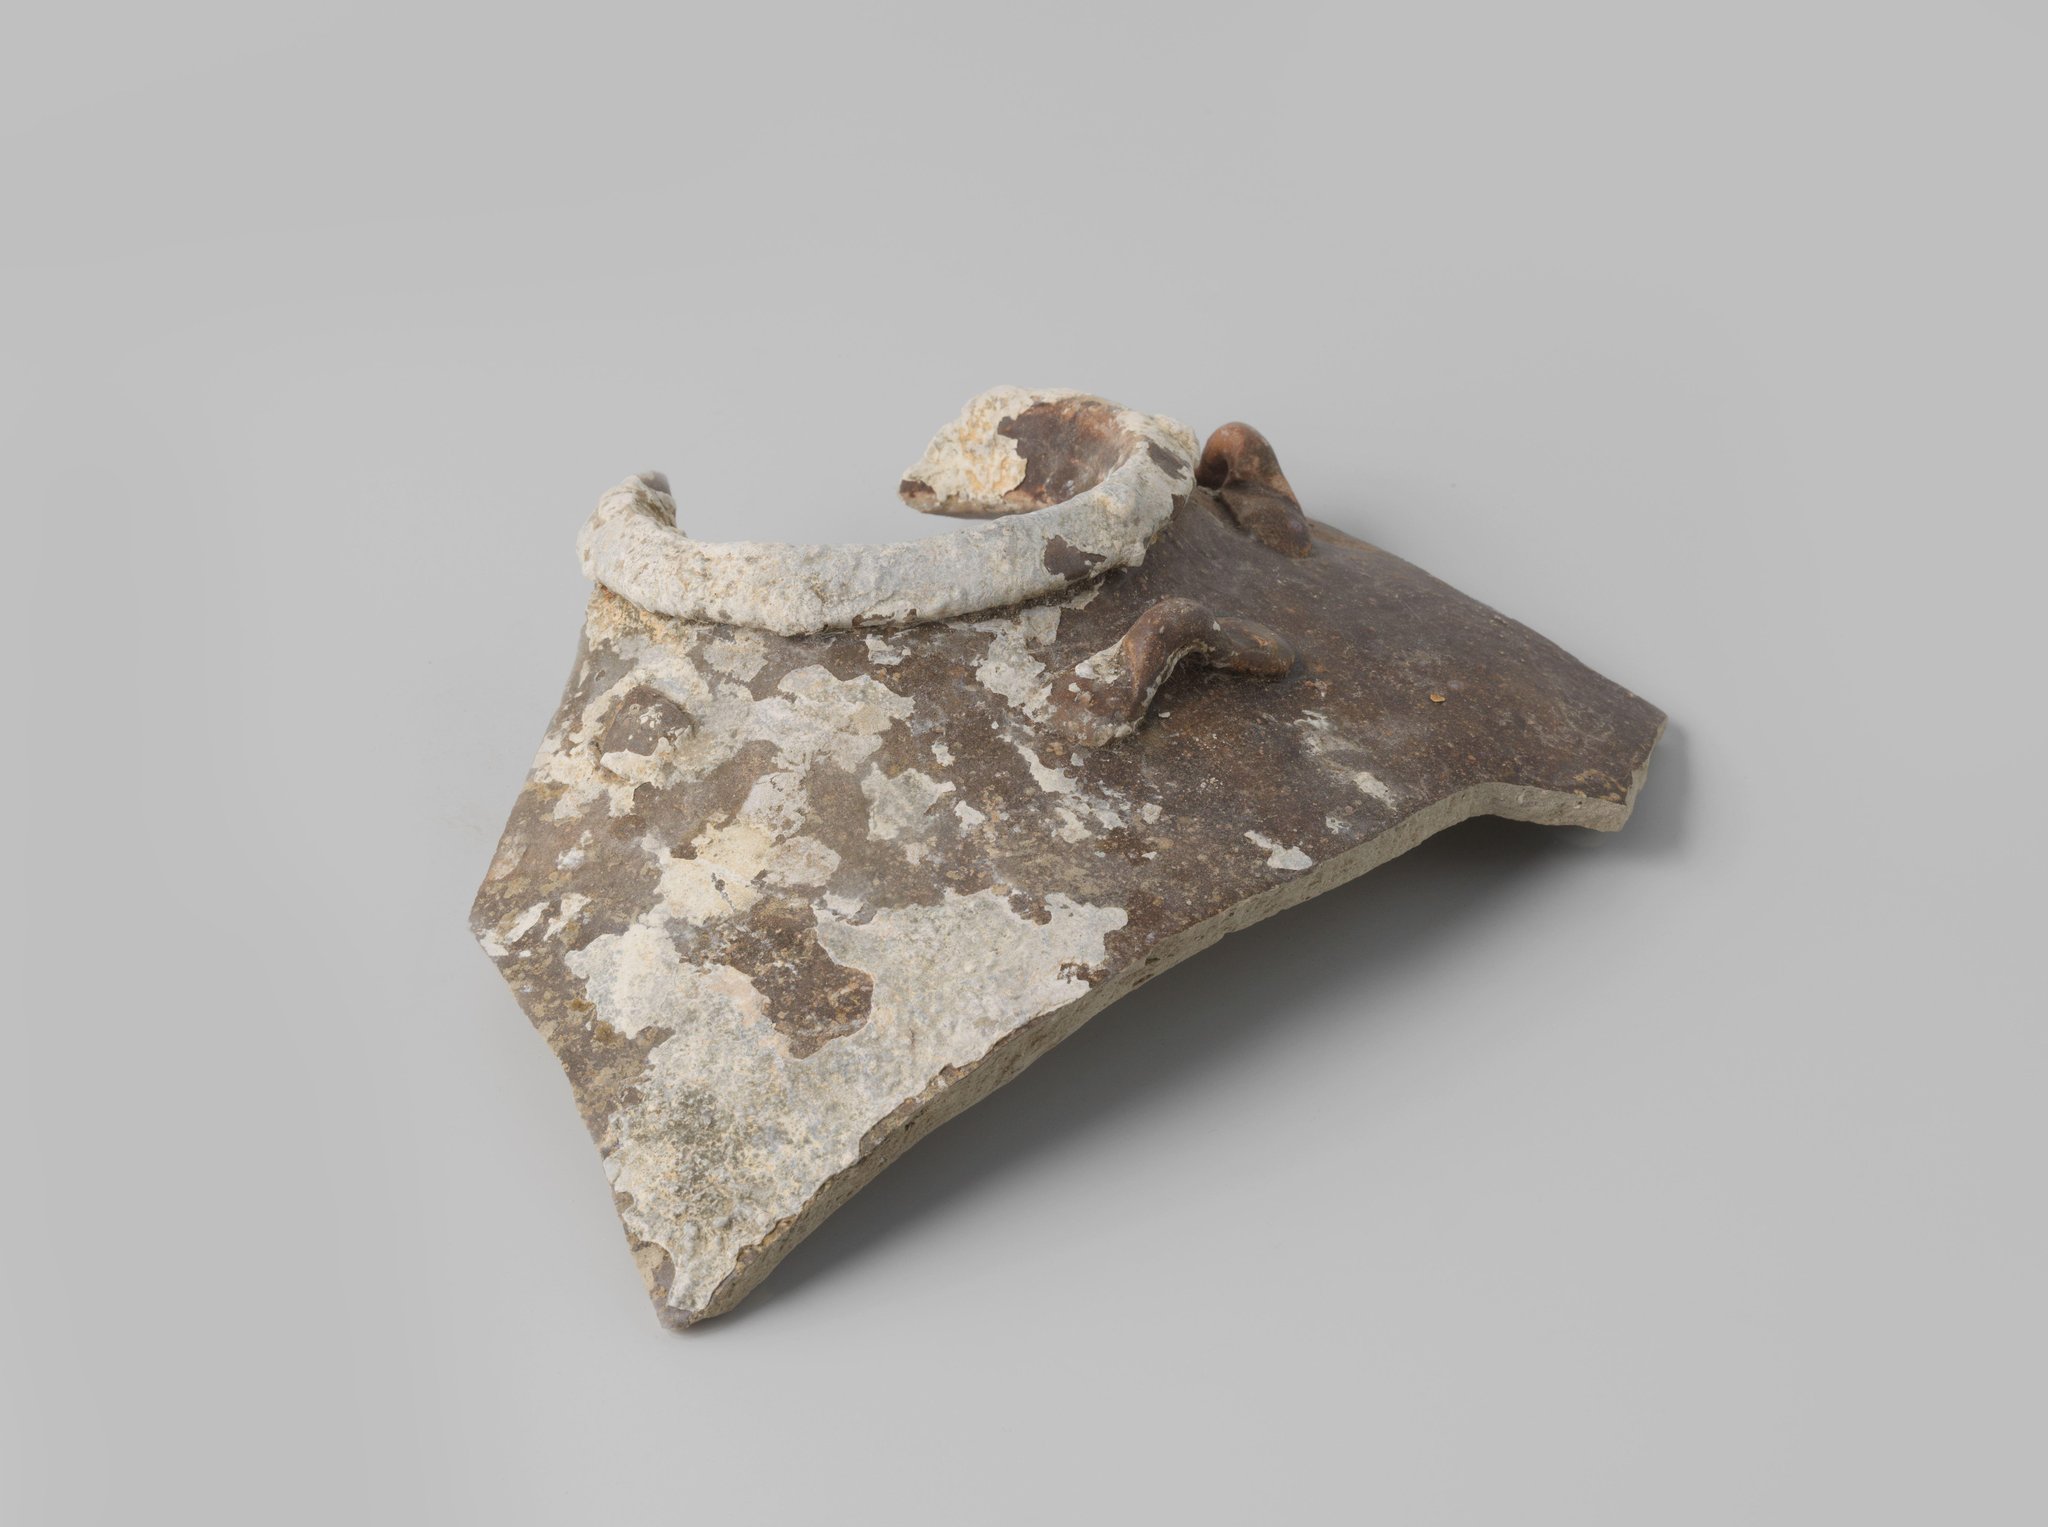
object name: sherd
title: Fragment martavaan uit V.O.C.-schip de 'Witte Leeuw'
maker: Anonymous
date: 1613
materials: porcelain, stoneware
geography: southeast asia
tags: verenigde oostindische compagnie, sint-helena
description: A jar. This exceptional jar has a wide waist and narrows towards the neck which ends in a narrow flaring mouth. The thin, double walled base has bursted open. The grey coloured clay contains few impurities. There are no traces of glaze on the outside or inside. It ha possibly been covered with a glaze or a slip. The upper half of the exterior has concentric grooves neatly incised from the neck to the waist.